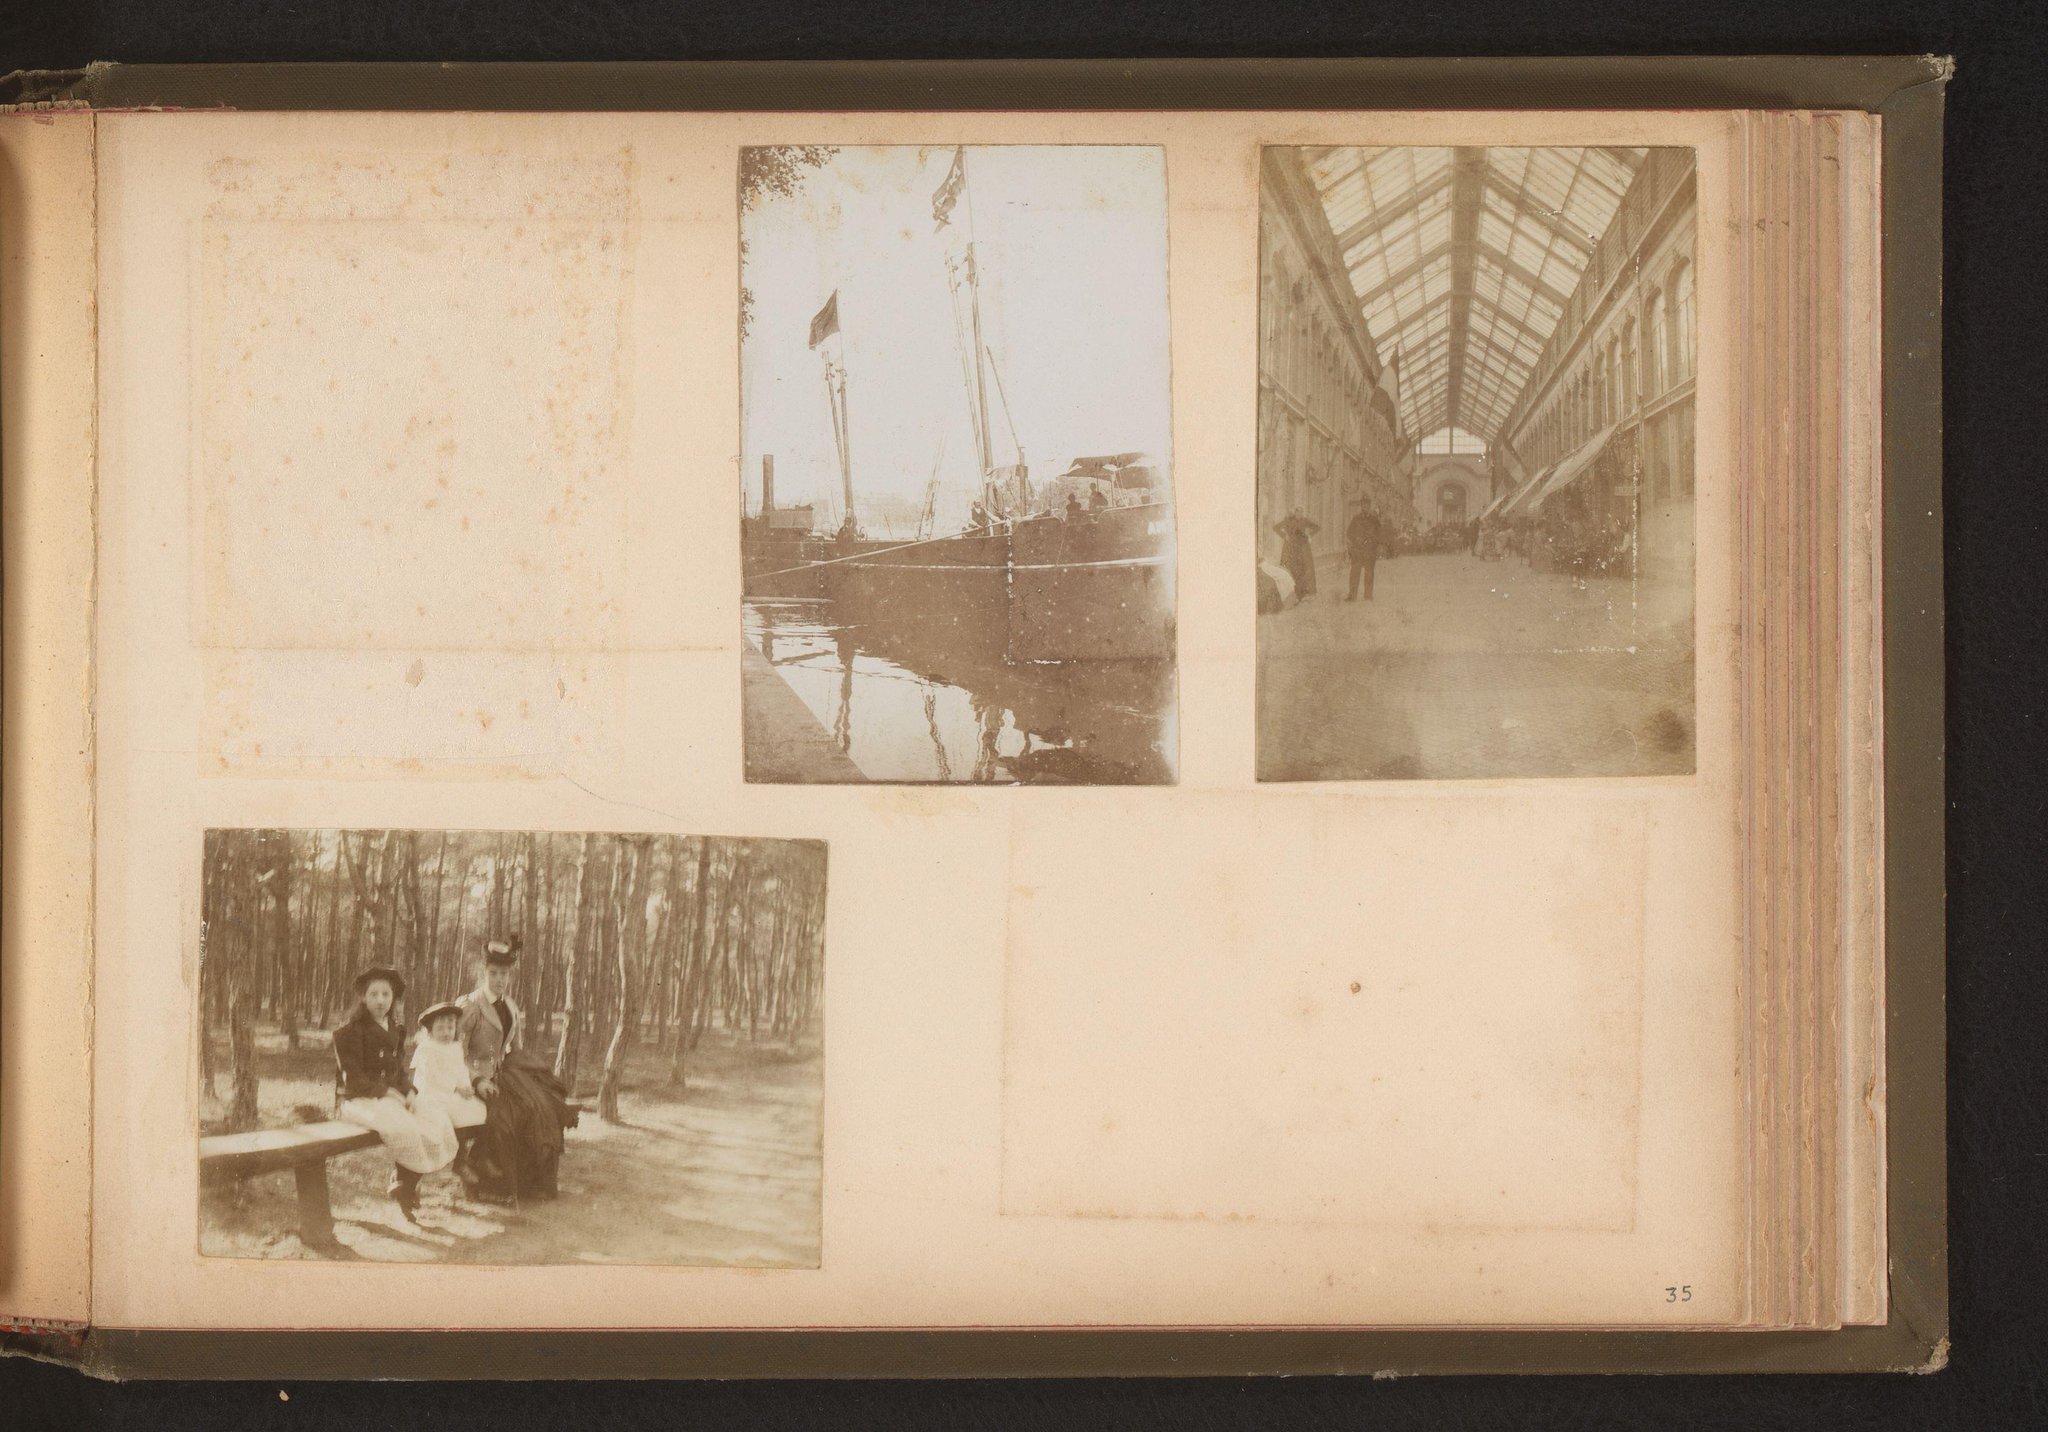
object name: photograph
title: Drie foto's van een vrouw met kinderen, een schip en een galerij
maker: Anonymous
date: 1895-1910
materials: paper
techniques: collodion silver print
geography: netherlands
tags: ships (in general), mother and child(ren), woman and child(ren) (family group), market-hall, netherlands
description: Deze foto's maken deel uit van een album.